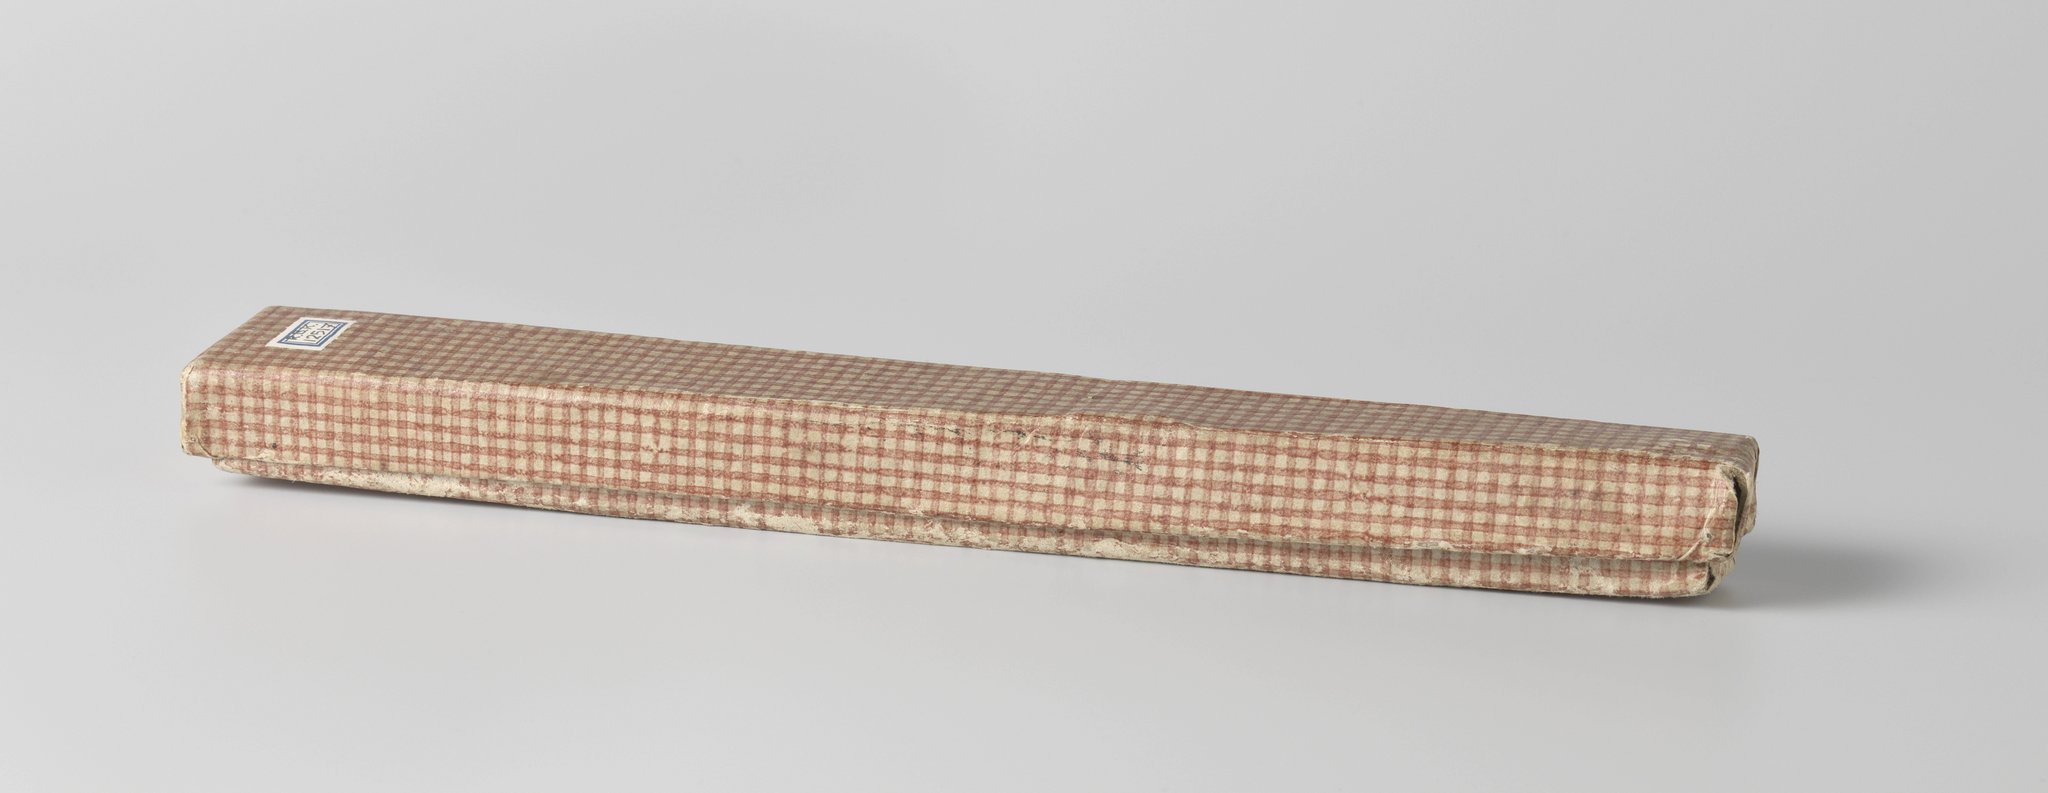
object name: waaierdoos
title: Waaierdoos van papier, buitenzijde beplakt met papier van ruitmotief, binnenzijde blauwgrijs beplakt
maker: Anonymous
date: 1775-1780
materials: paint, paper, watercolor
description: Waaierdoos van papier, buitenzijde beplakt met papier van ruitmotief, binnenzijde blauwgrijs beplakt